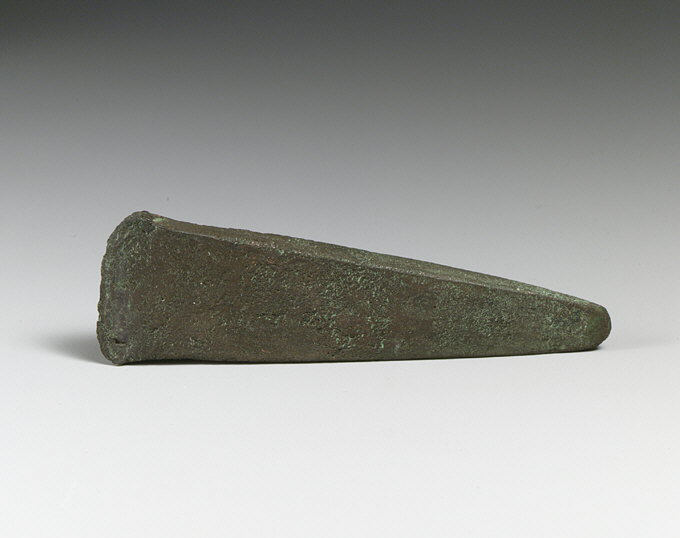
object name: axehead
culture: cypriot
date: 3900 BCE-100 CE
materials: bronze